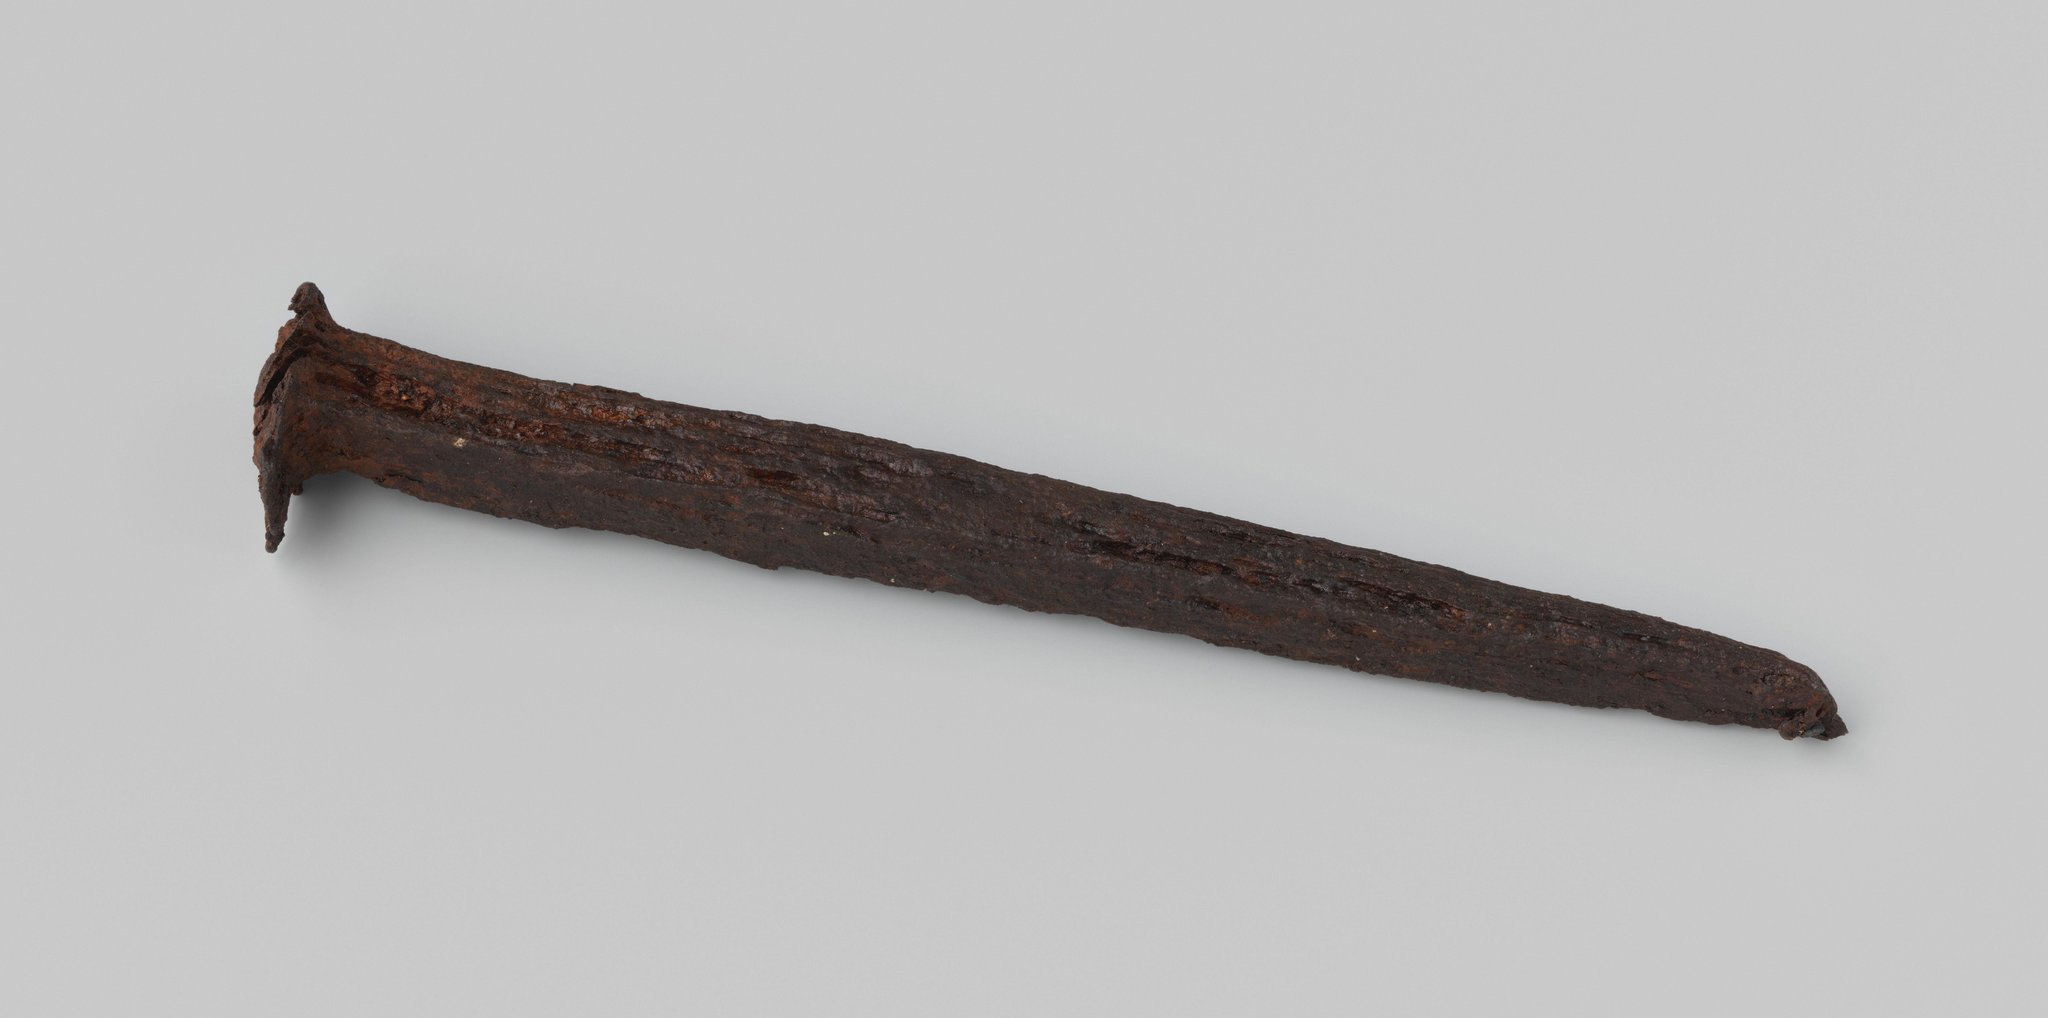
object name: nagel, spijker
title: Spijker afkomstig uit het wrak van de Oost-Indiëvaarder Hollandia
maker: Anonymous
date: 1700-1743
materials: iron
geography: netherlands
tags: verenigde oostindische compagnie, hollandia (schip)